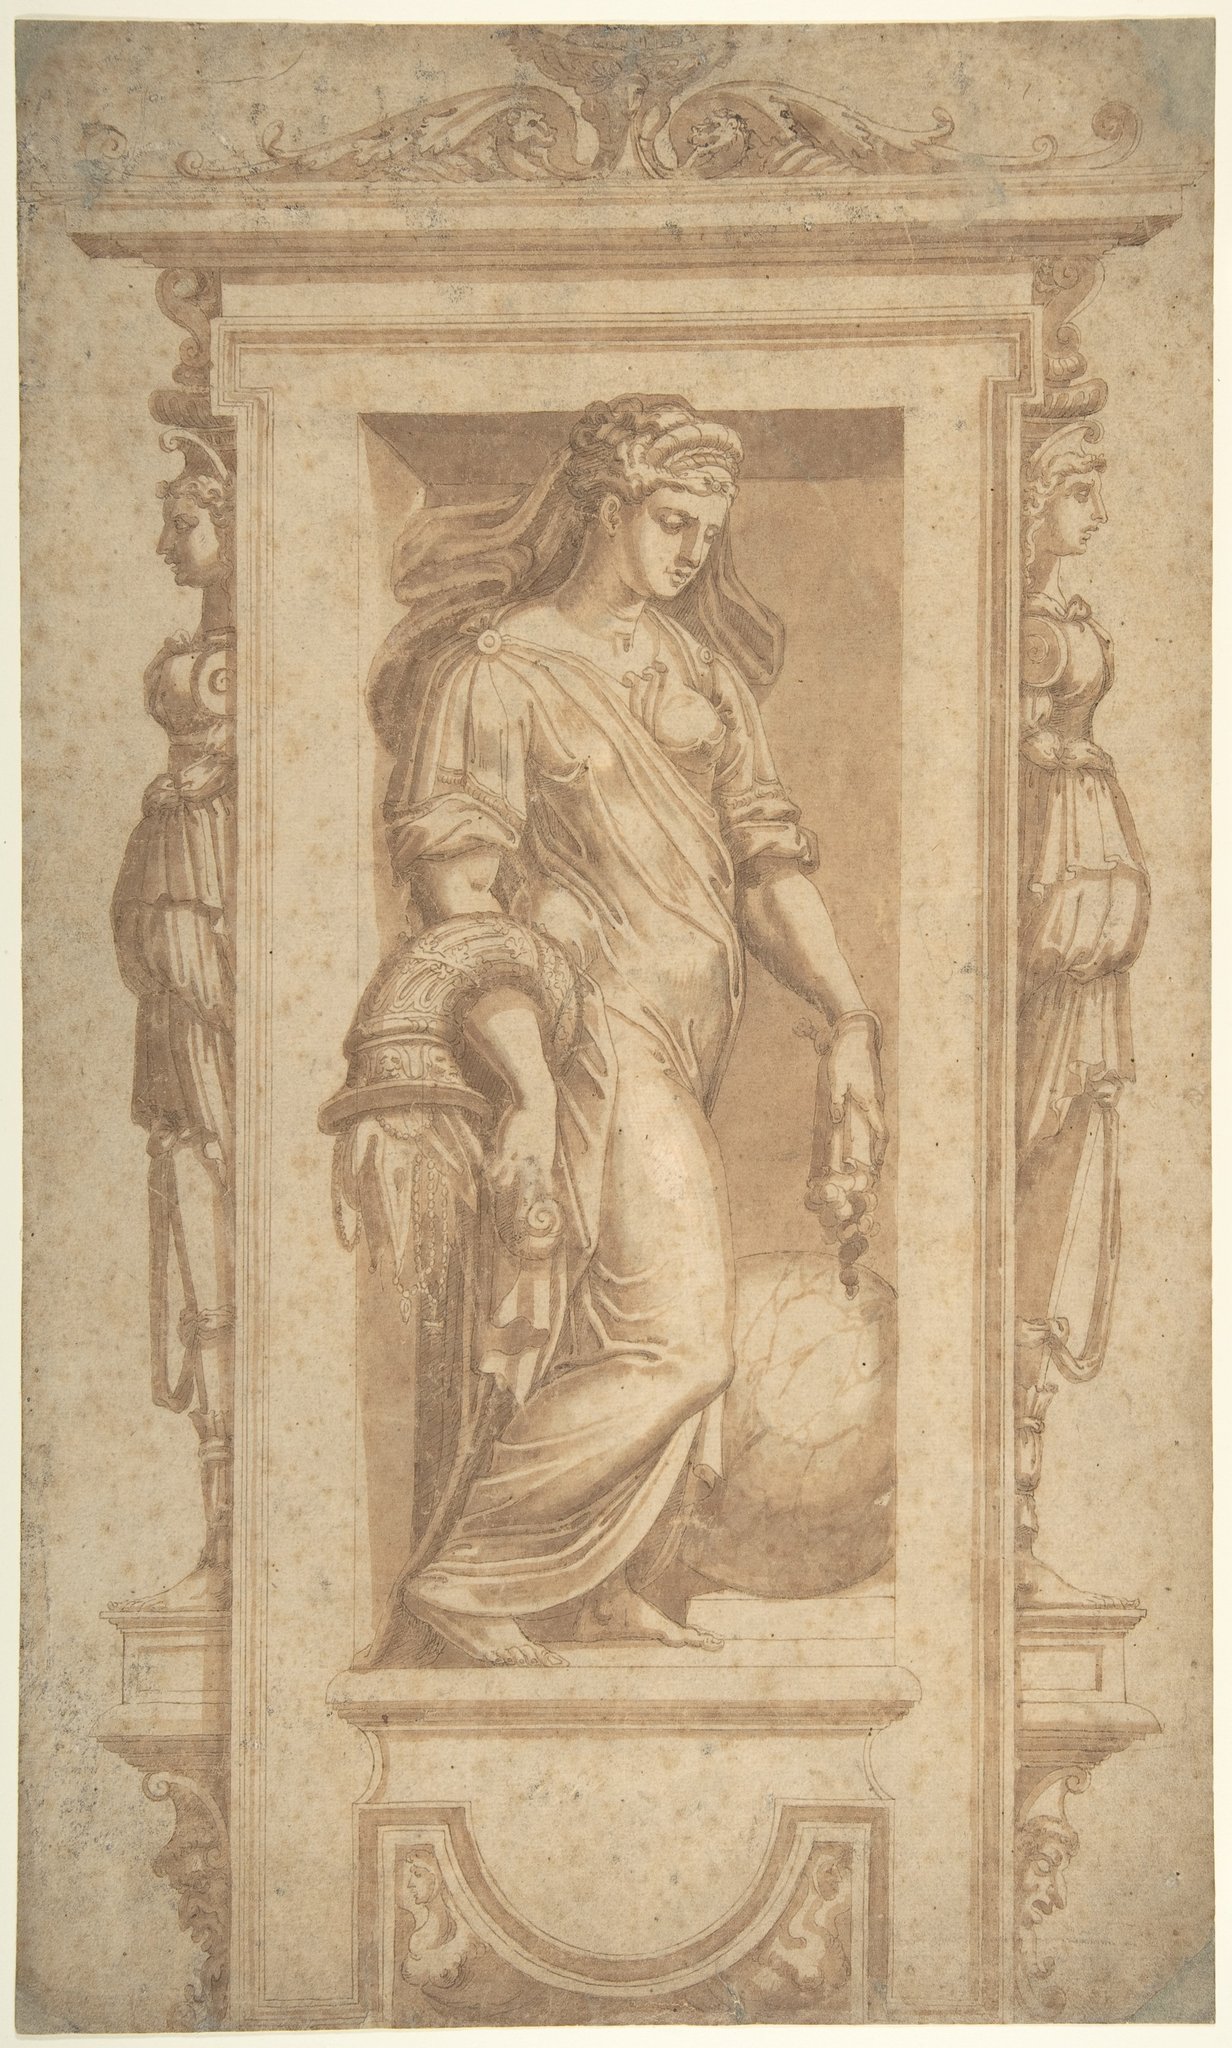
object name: drawing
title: Female Allegorical Figure of Benignitas (Goodness), with Attributes of Abundance Standing in a Niche (recto); Architectural Sketches (verso)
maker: giorgio vasari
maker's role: artist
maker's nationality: italian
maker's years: 1511-1574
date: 1550-1570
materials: chalk, ink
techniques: brush, pen, drawing, wash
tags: women